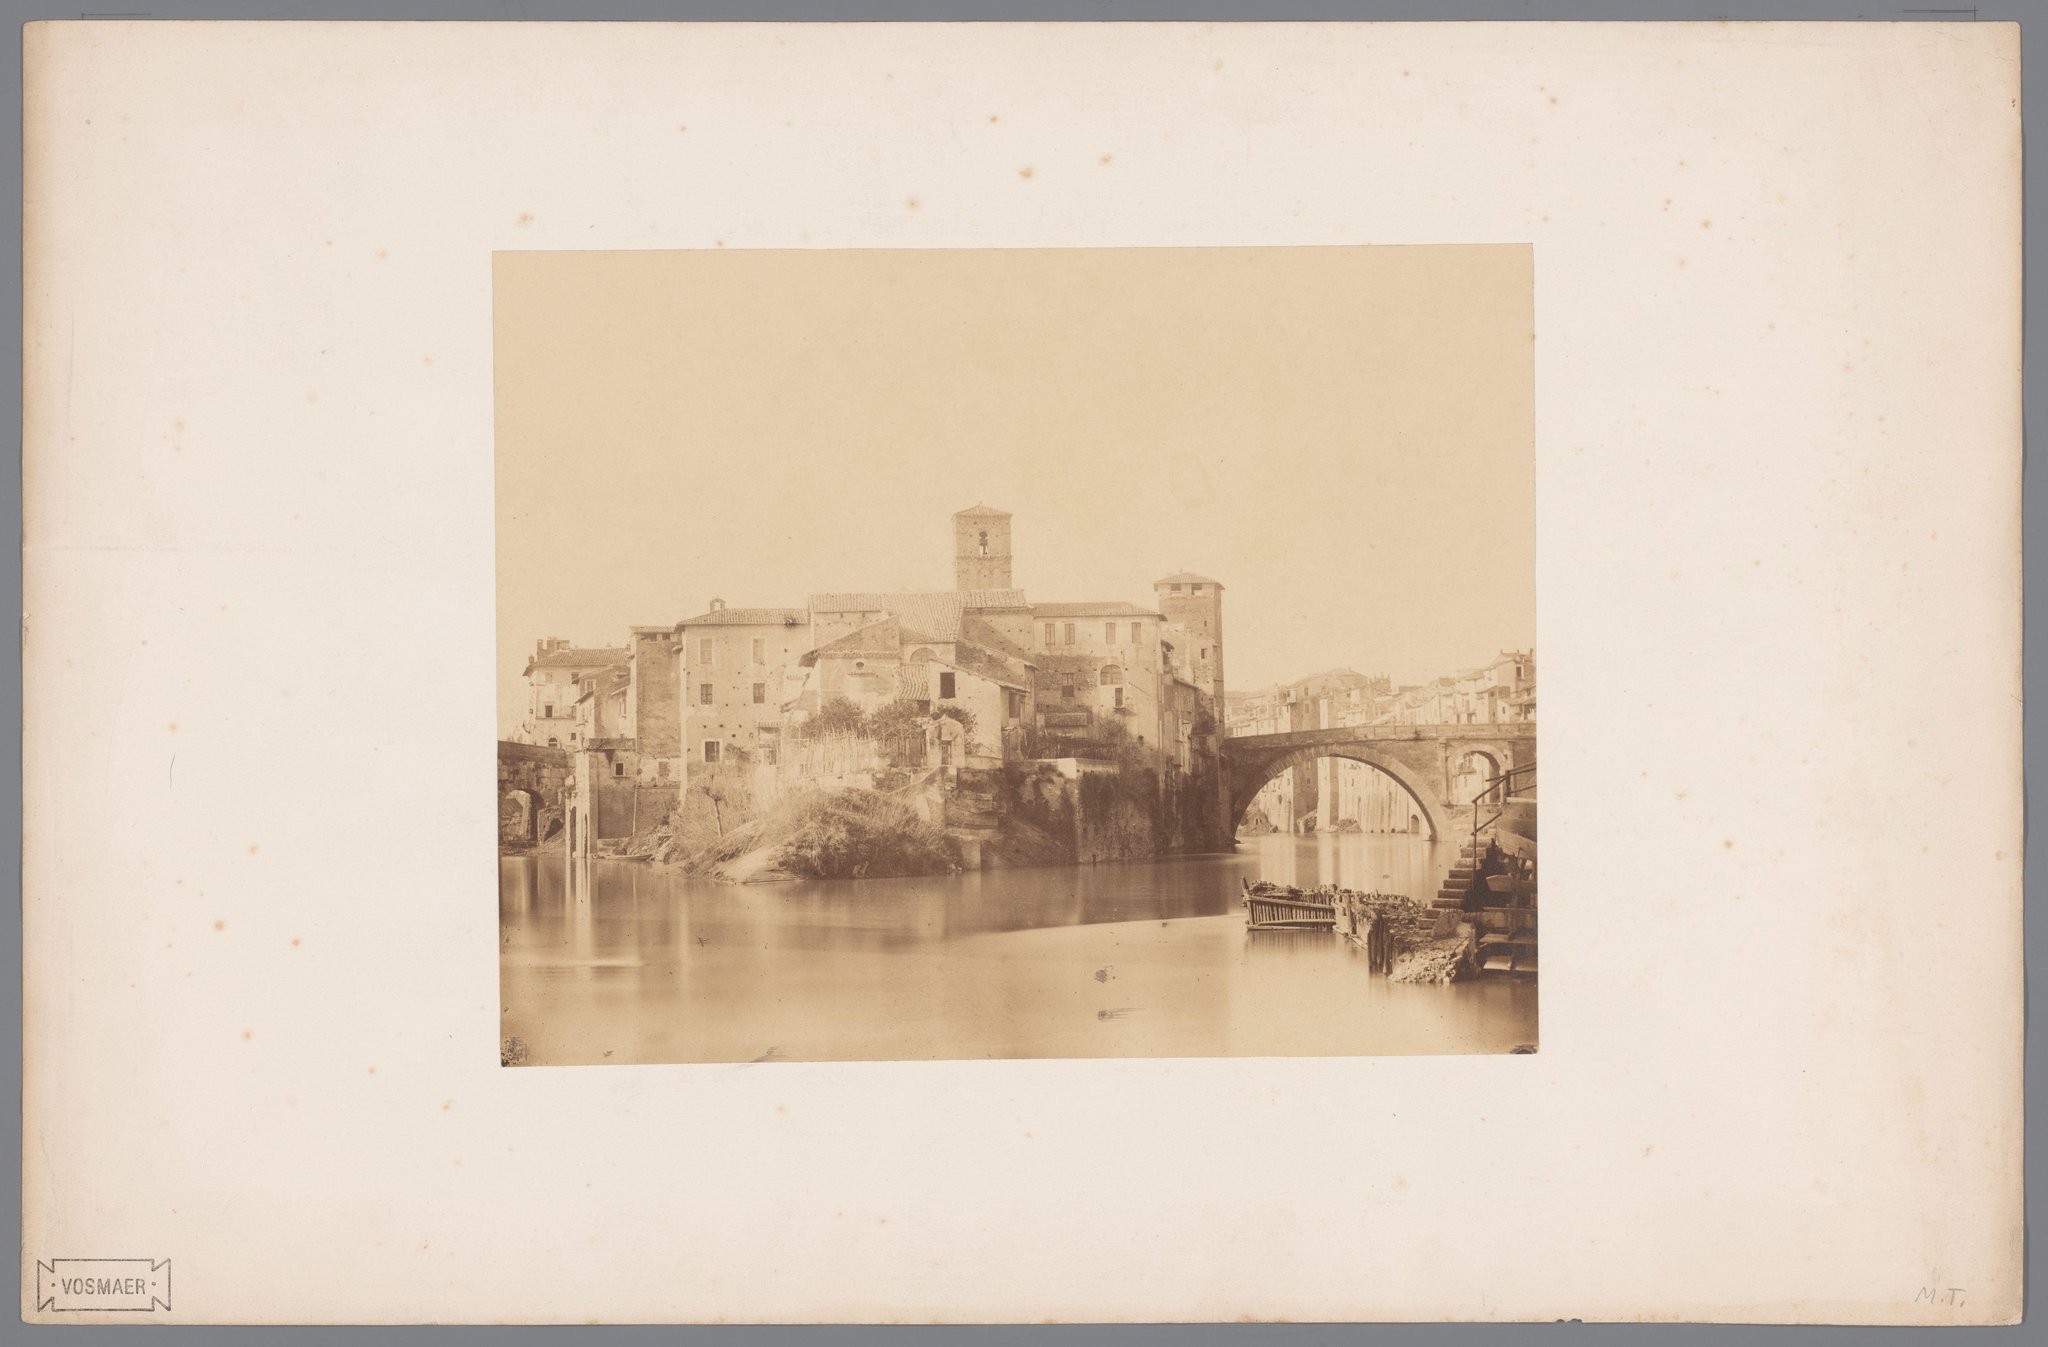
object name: photograph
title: Gezicht op een stad aan een rivier te Italië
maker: Anonymous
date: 1851-1900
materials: cardboard, paper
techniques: albumen print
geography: italy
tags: city-view in general; 'veduta', river, landscape with bridge, viaduct or aqueduct, italy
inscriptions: inscription: ‘Ital B Anon’, inscription: ‘M.T.’, collector's mark: ‘VOSMAER’